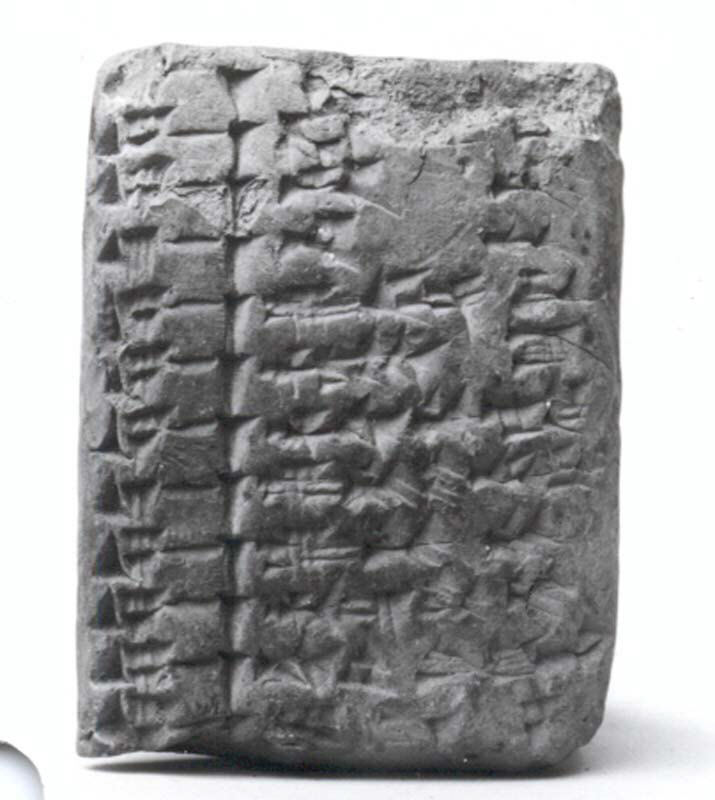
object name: cuneiform tablet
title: Cuneiform tablet: account of workmen, Ebabbar archive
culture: babylonian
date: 598 BCE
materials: clay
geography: mesopotamia